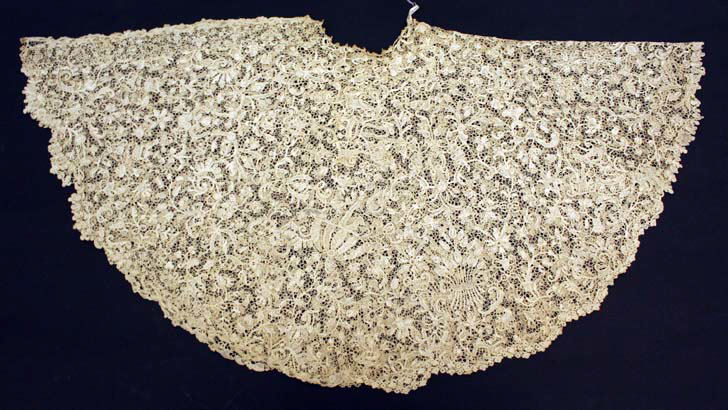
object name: cape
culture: french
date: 1734-1766